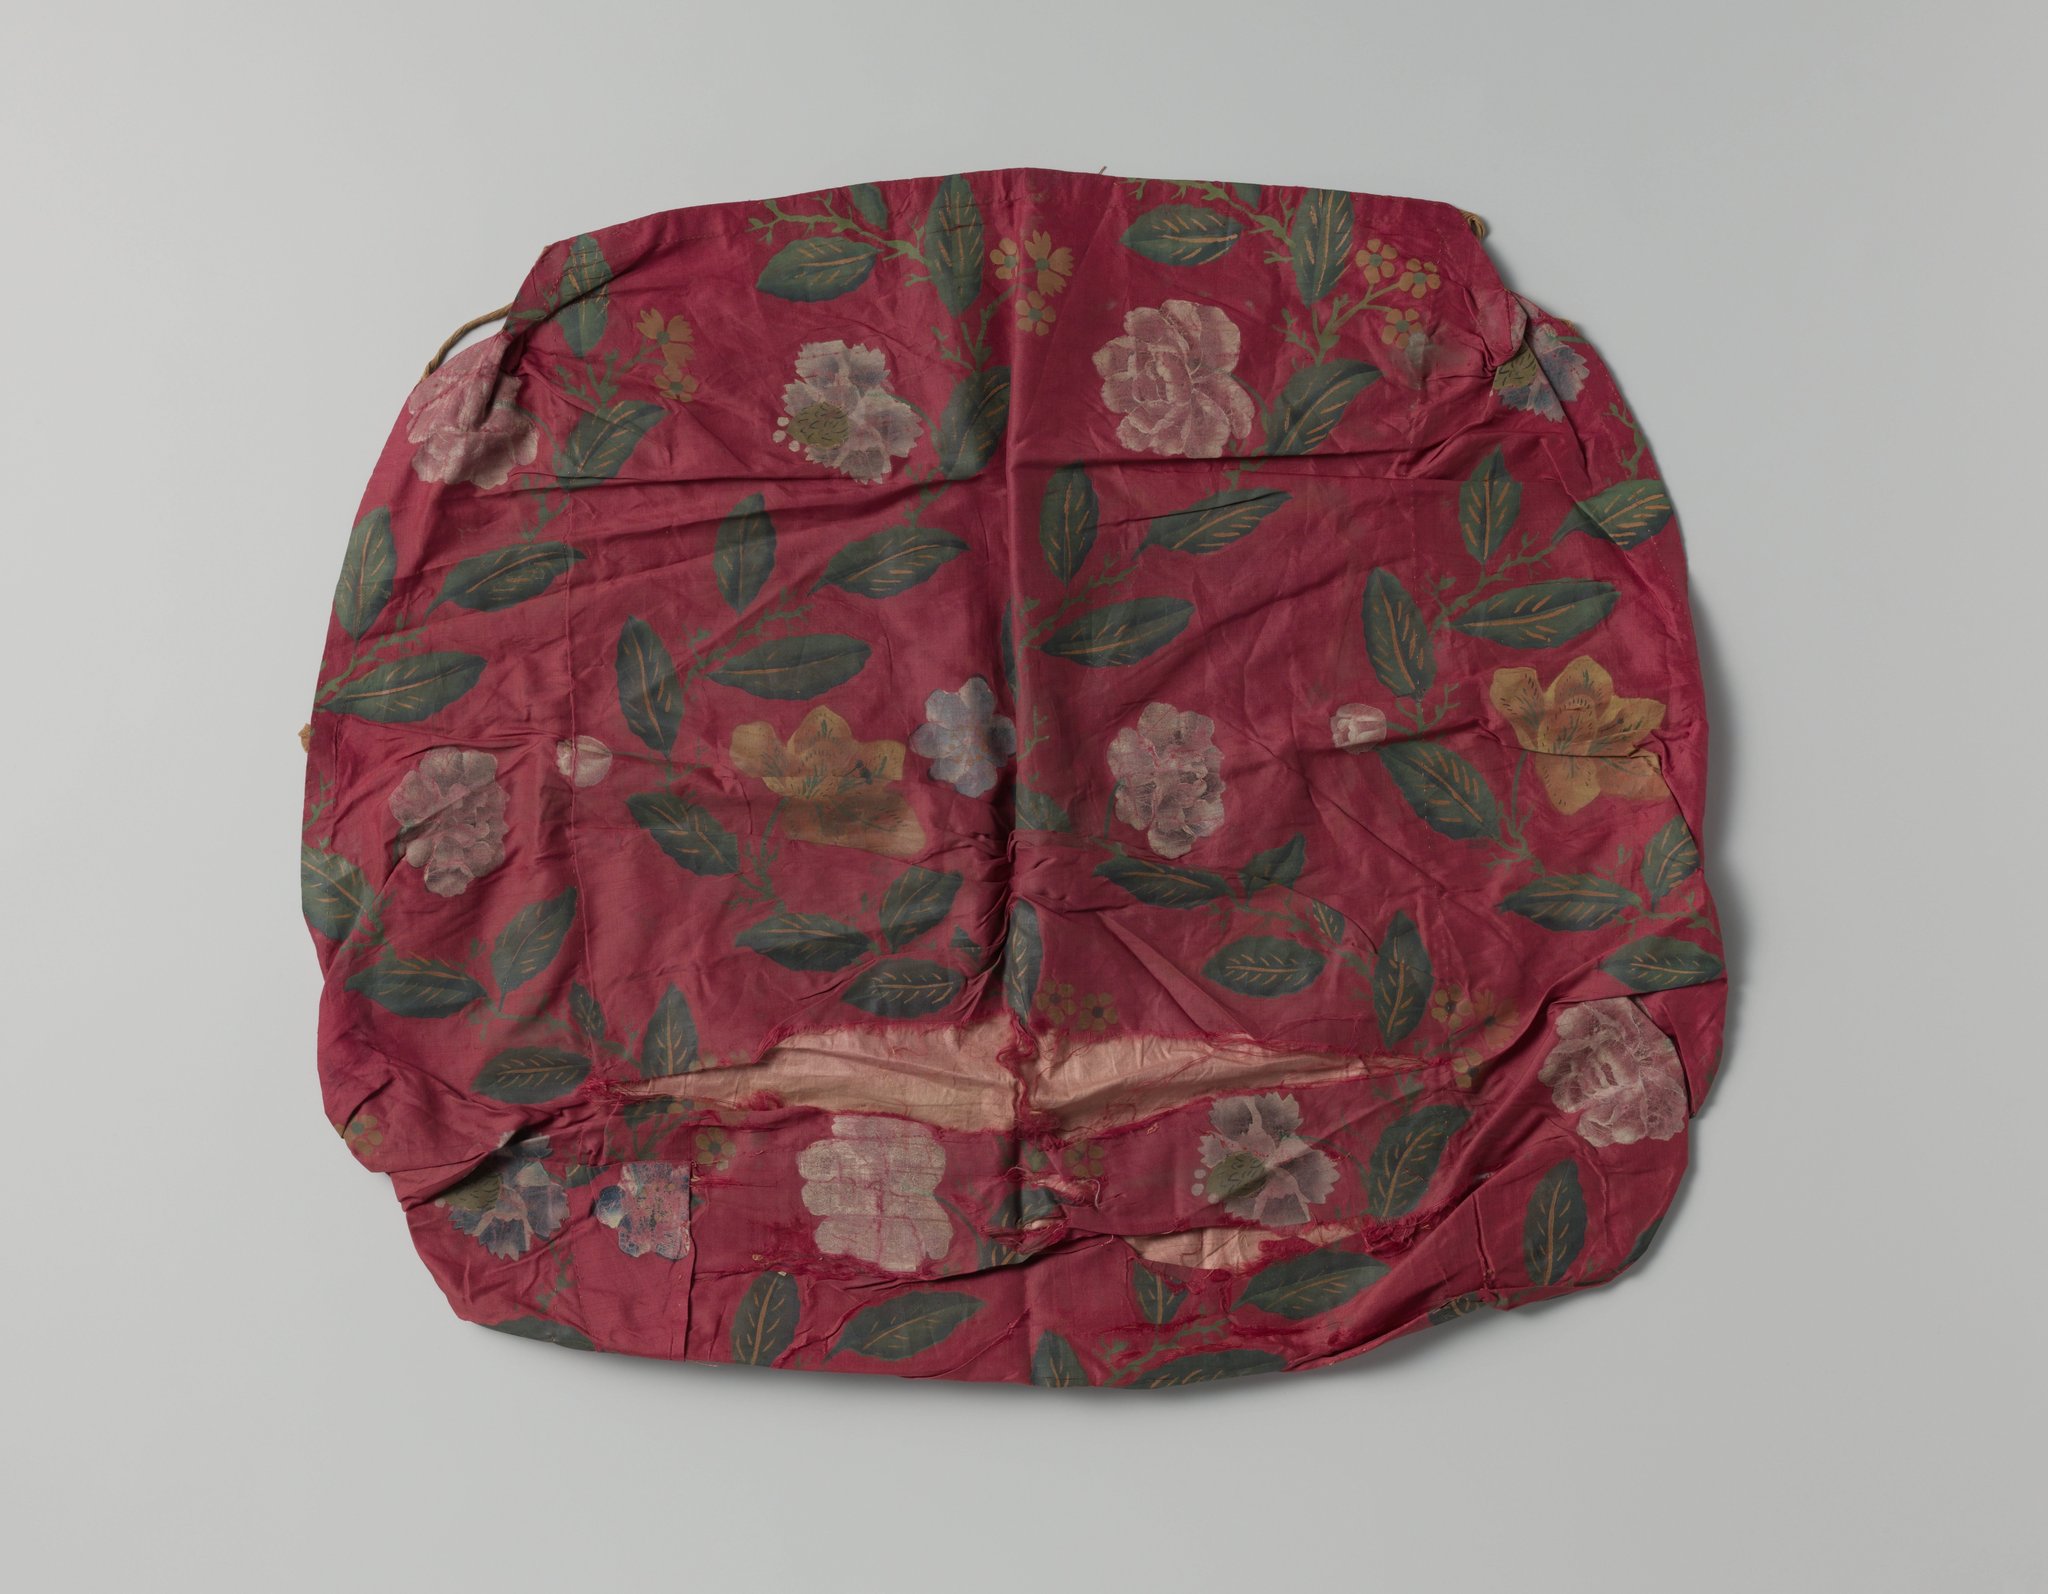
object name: covering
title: Hoes voor stoelzitting, van bedrukte zijde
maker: Anonymous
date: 1770-1780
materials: linen, paint, silk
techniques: printing, weave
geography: france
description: Drie hoezen voor stoelzittingen. De hoezen zijn gemaakt van bedrukte zijde. Op een rode grond zijn veelkleurige bloemtakken gedrukt. De hoezen hebben een linnen voering.